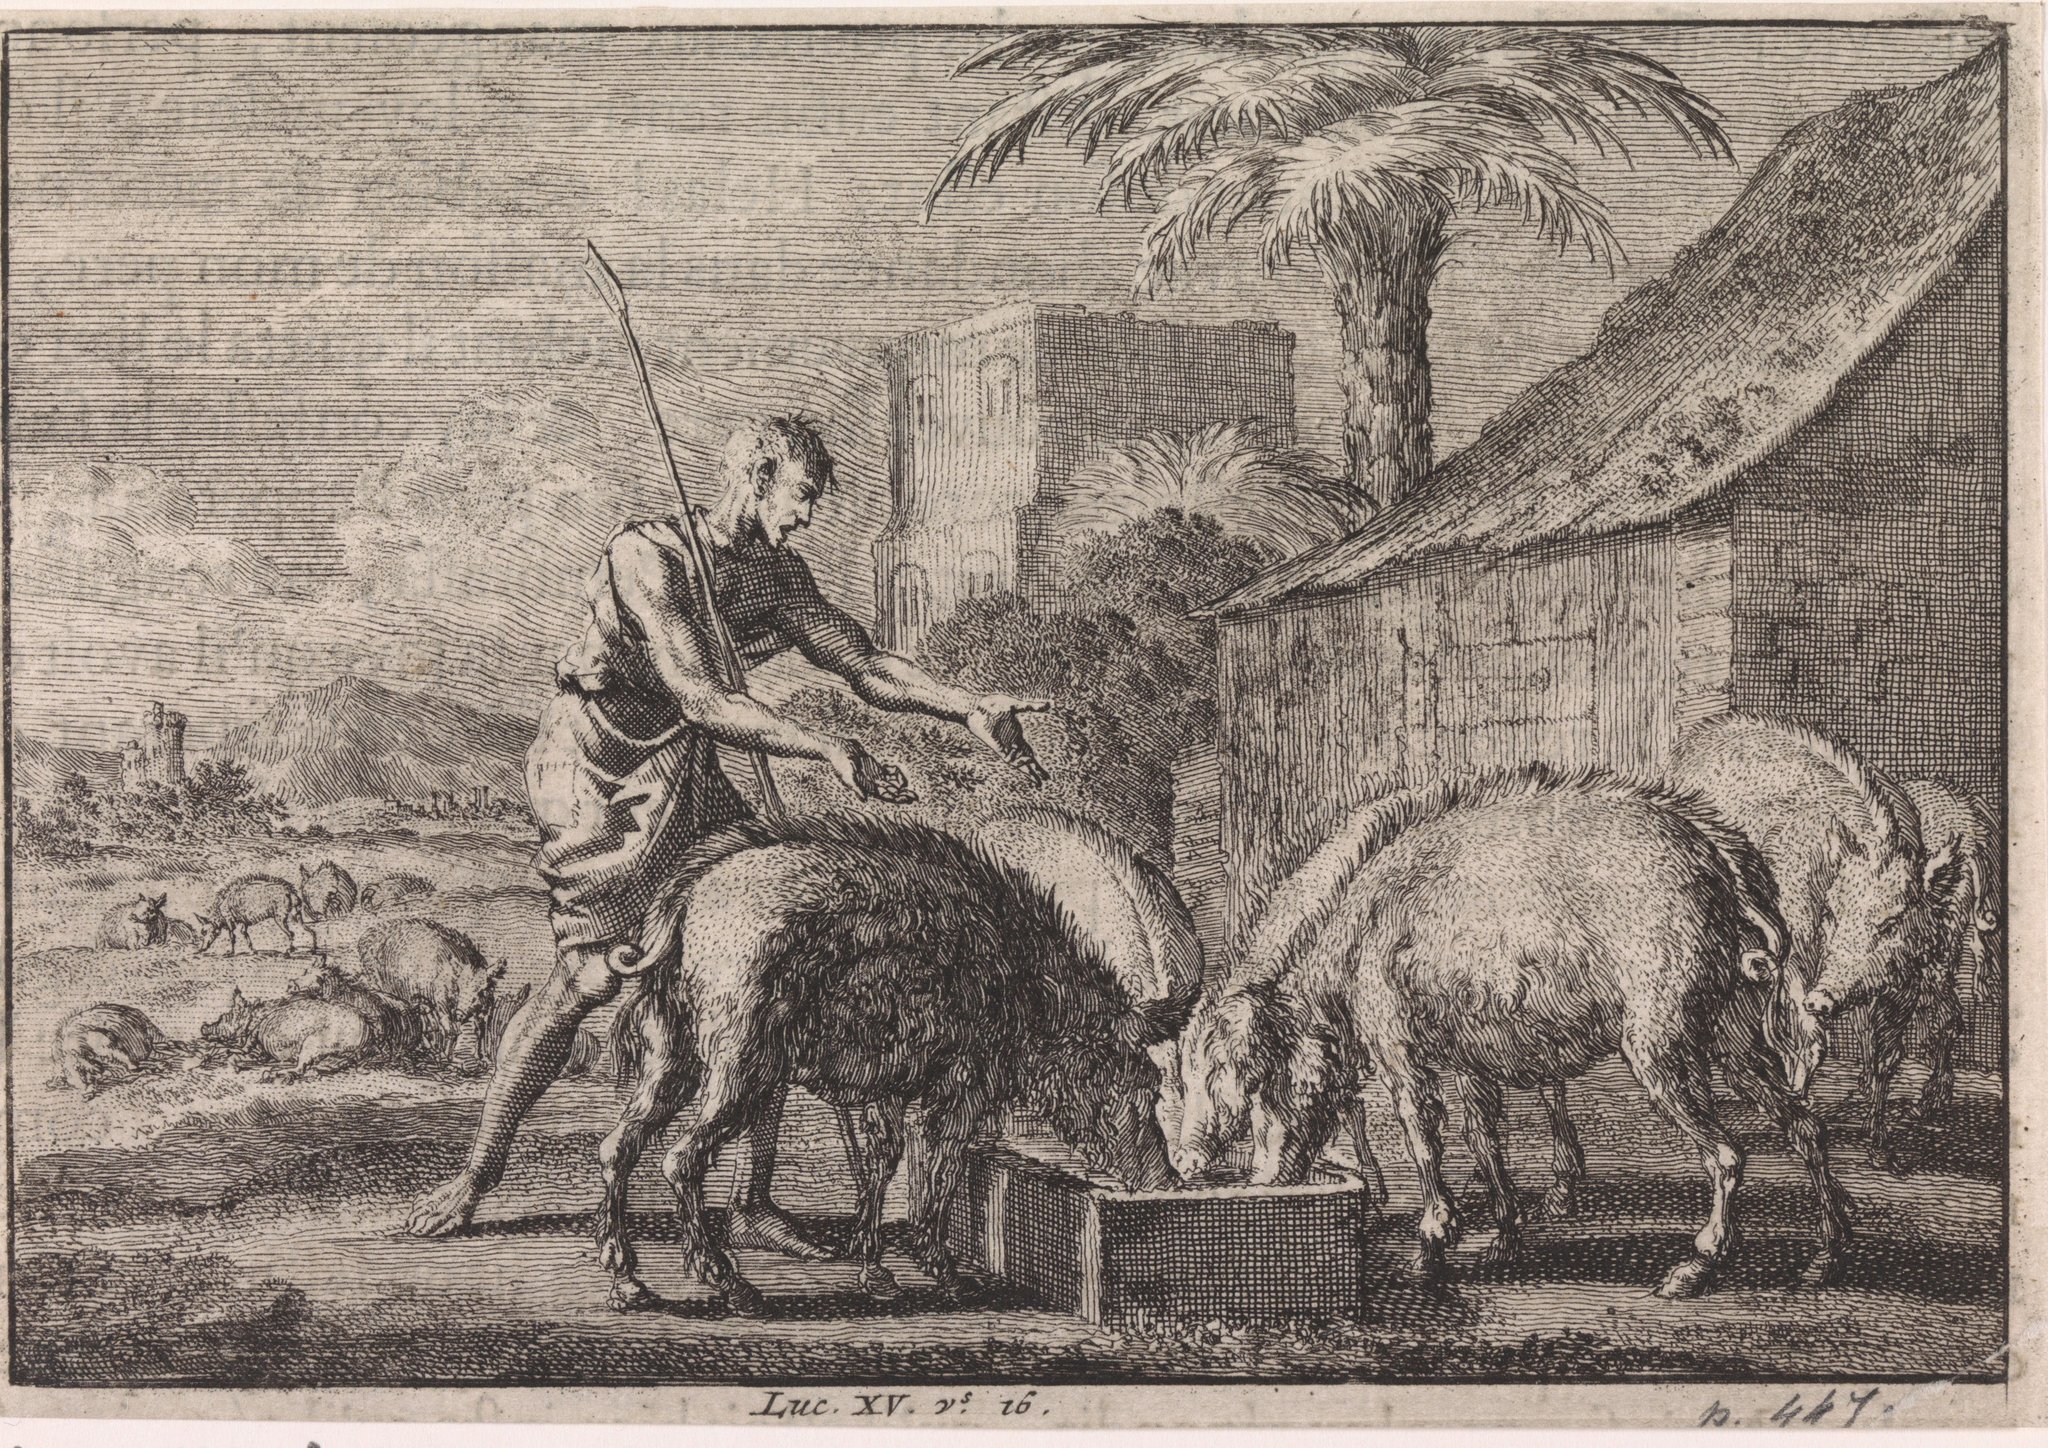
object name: print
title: Verloren Zoon als varkenshoeder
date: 1703-1762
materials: paper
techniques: etching, letterpress printing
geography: amsterdam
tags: the prodigal son tends the swine and eats from their trough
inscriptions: collector's mark: Lugt 2228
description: De prent komt een eerste keer voor als boekillustratie voor David Martin. Historie des Ouden en Nieuwen Testaments. Amsterdam, Pieter Mortier, 1703. Deel II. De boekillustraties voor de Mortierbijbel hebben verschillende staten en kopieën, waarbij de chronologische volgorde moeilijk te achterhalen valt. Als boekillustraties werden ze bovendien herhaaldelijk opnieuw gebruikt voor andere boekwerken.